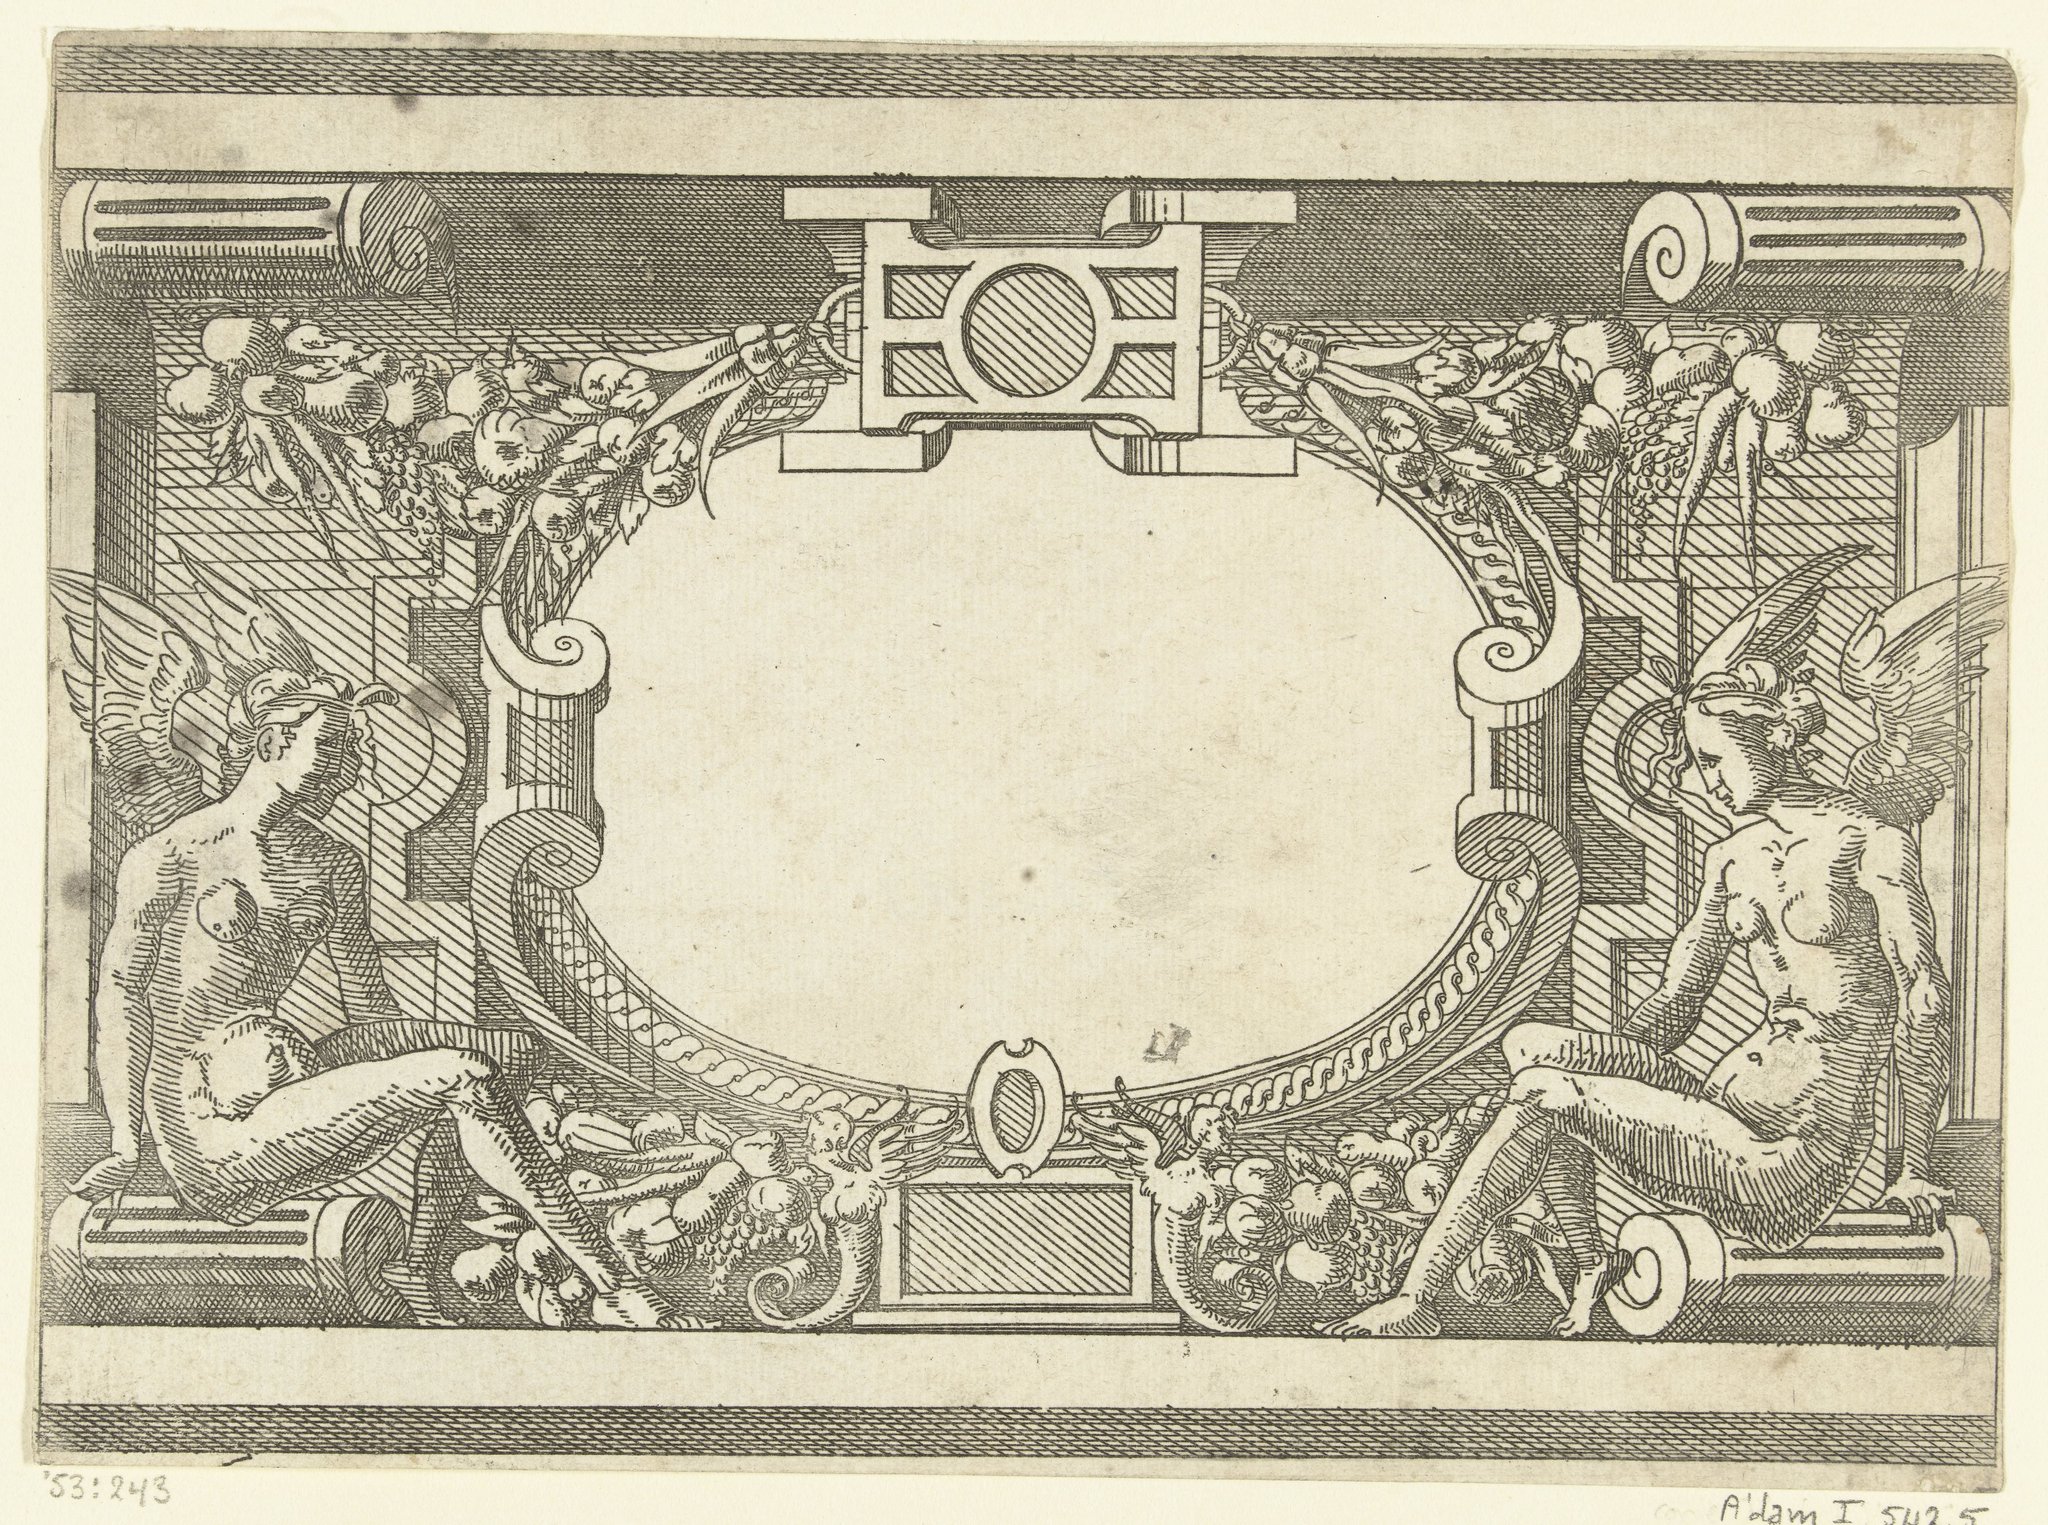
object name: ornament print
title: Kleine cartouche naar voorbeeld te Fontainebleau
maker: Anonymous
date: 1520-1584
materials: paper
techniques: etching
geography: france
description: De engelen zitten linksonder en rechtsonder op een voluut van het rolwerk. Uit serie van 32 bladen. De cartouches zijn deels ontleend aan de prenten van Antonio Fantuzzi naar de decoratie van de Galerie van François 1er door Giovanni Battista Rosso. De serie staat ook bekend onder de titel Petits cartouches de Fontainebleau.